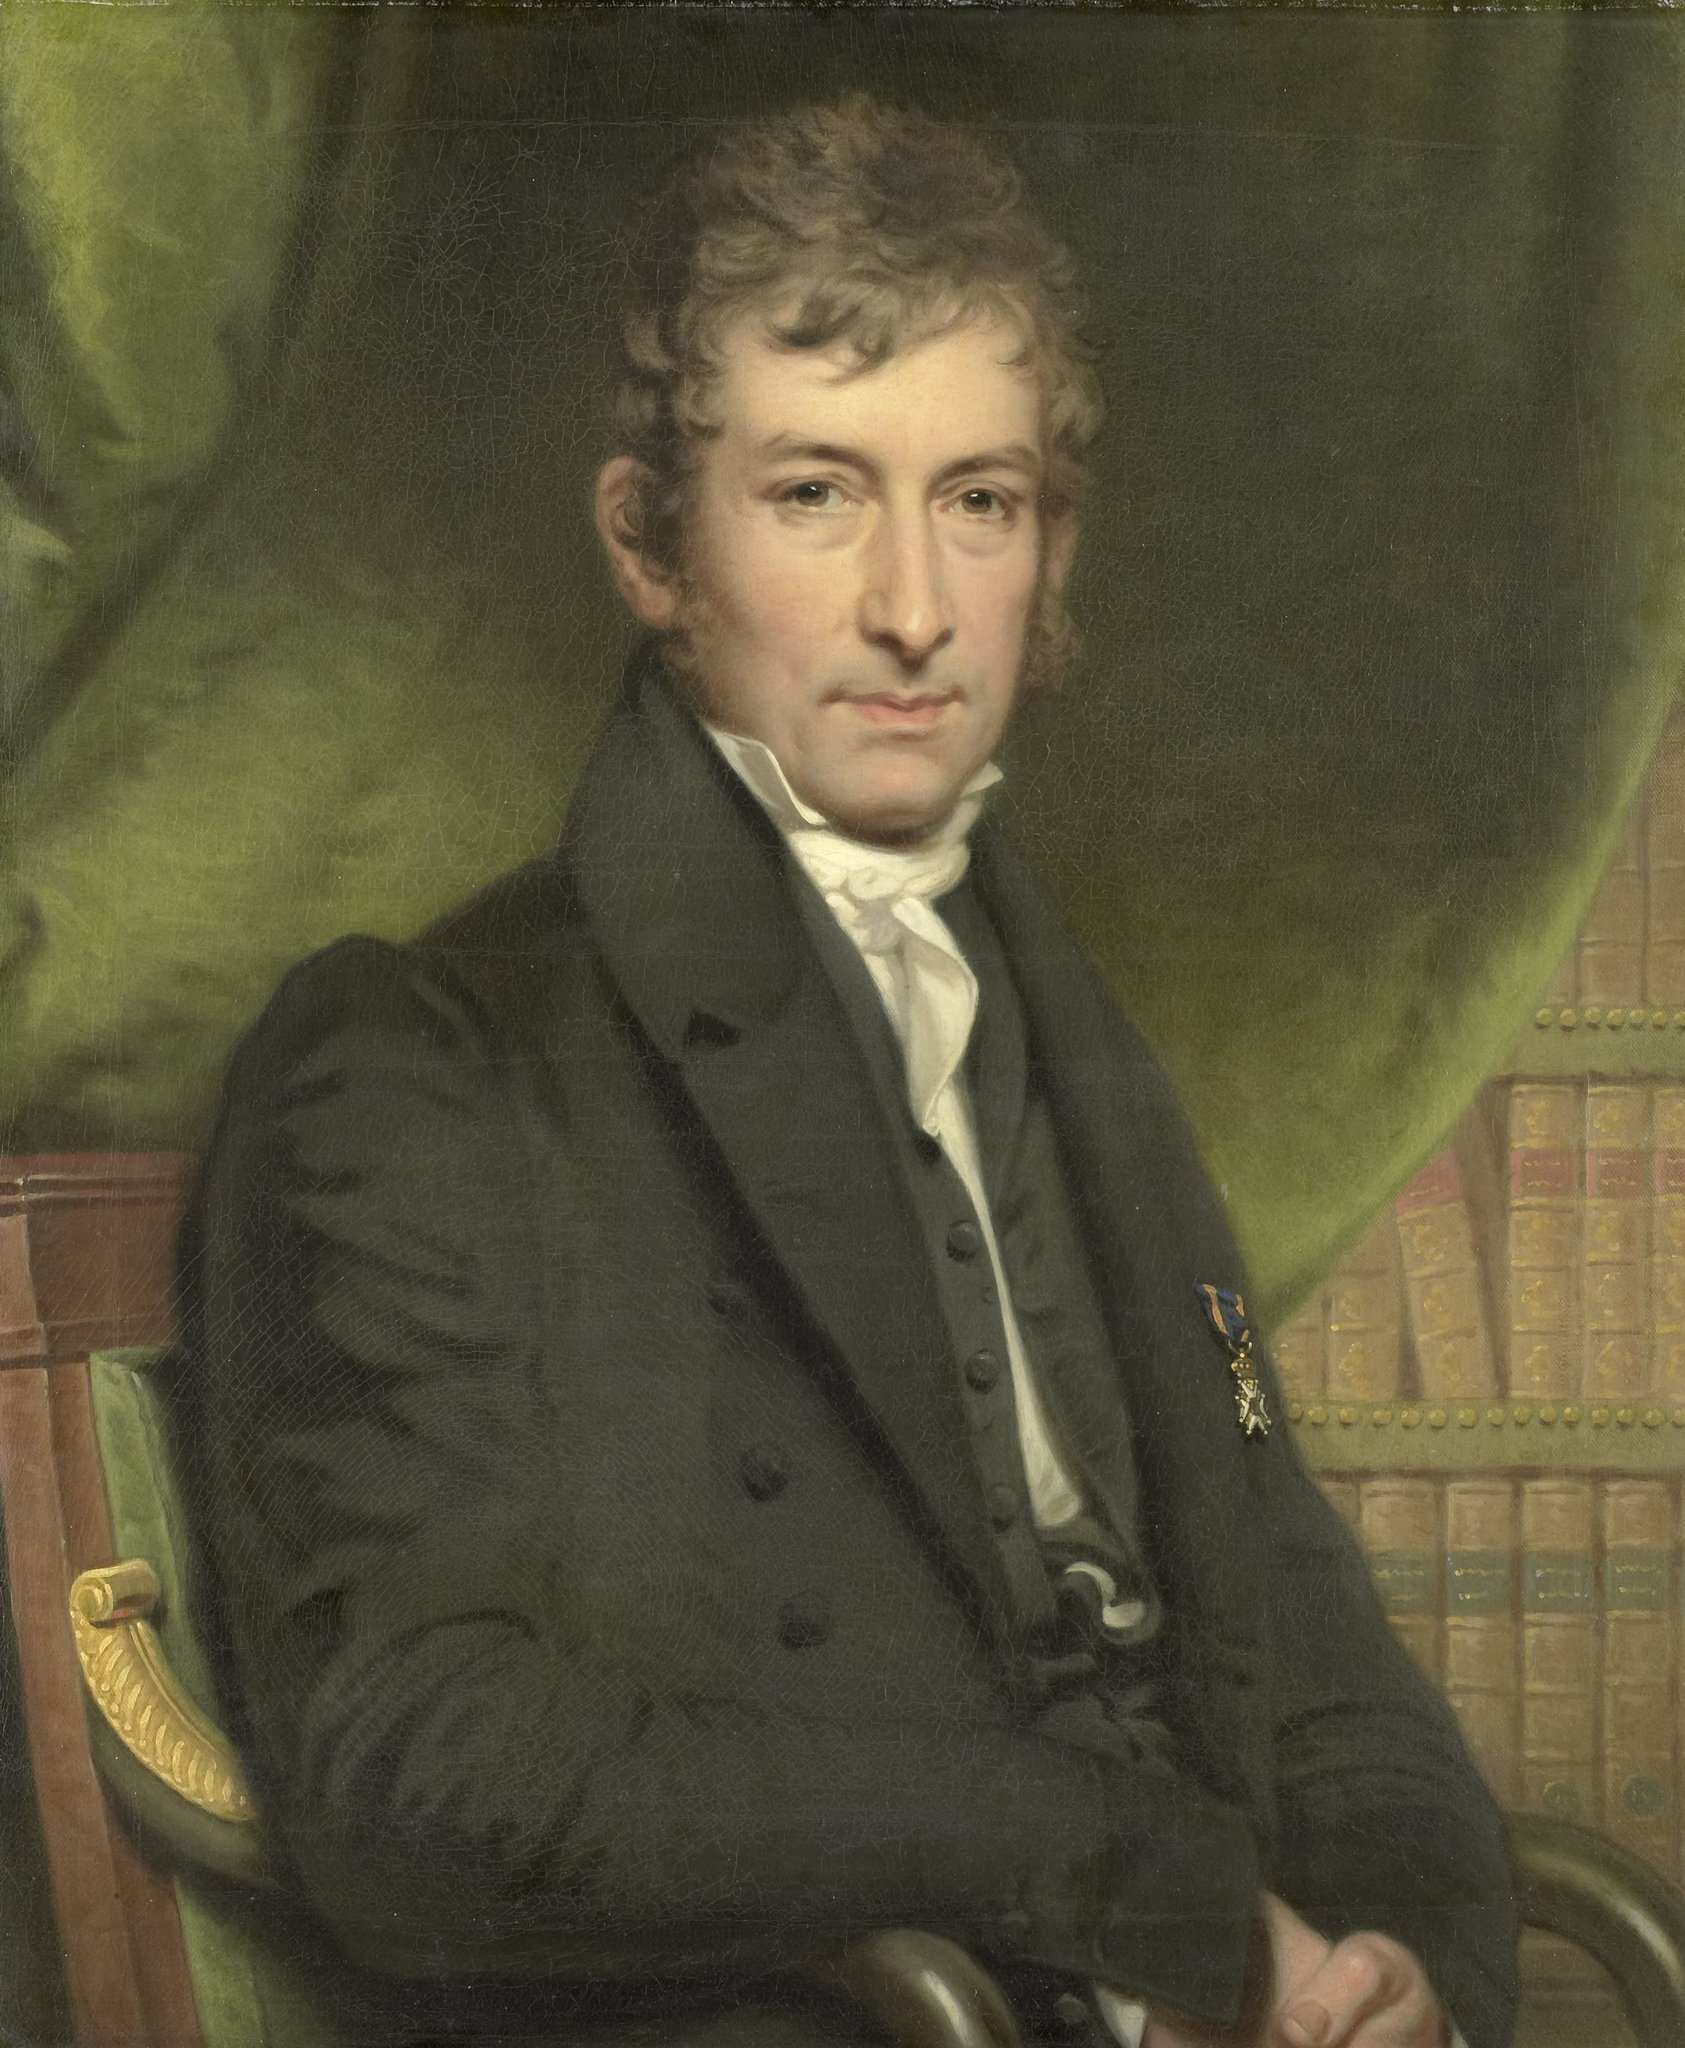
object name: painting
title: Johan Fraser (1780-1843)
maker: charles howard hodges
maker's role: draughtsman, painter, print maker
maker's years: 1764-1837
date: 1835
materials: canvas, oil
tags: amsterdam, historical persons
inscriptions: signature, date and inscription: ‘J: Fraser: geb: 1780: obit 1843 C: H: Hodges pinxit 1835’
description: Portret van Johan Fraser. Ten halven lijve, zittend in een stoel voor een boekenkast. Pendant van SK-A-1568.